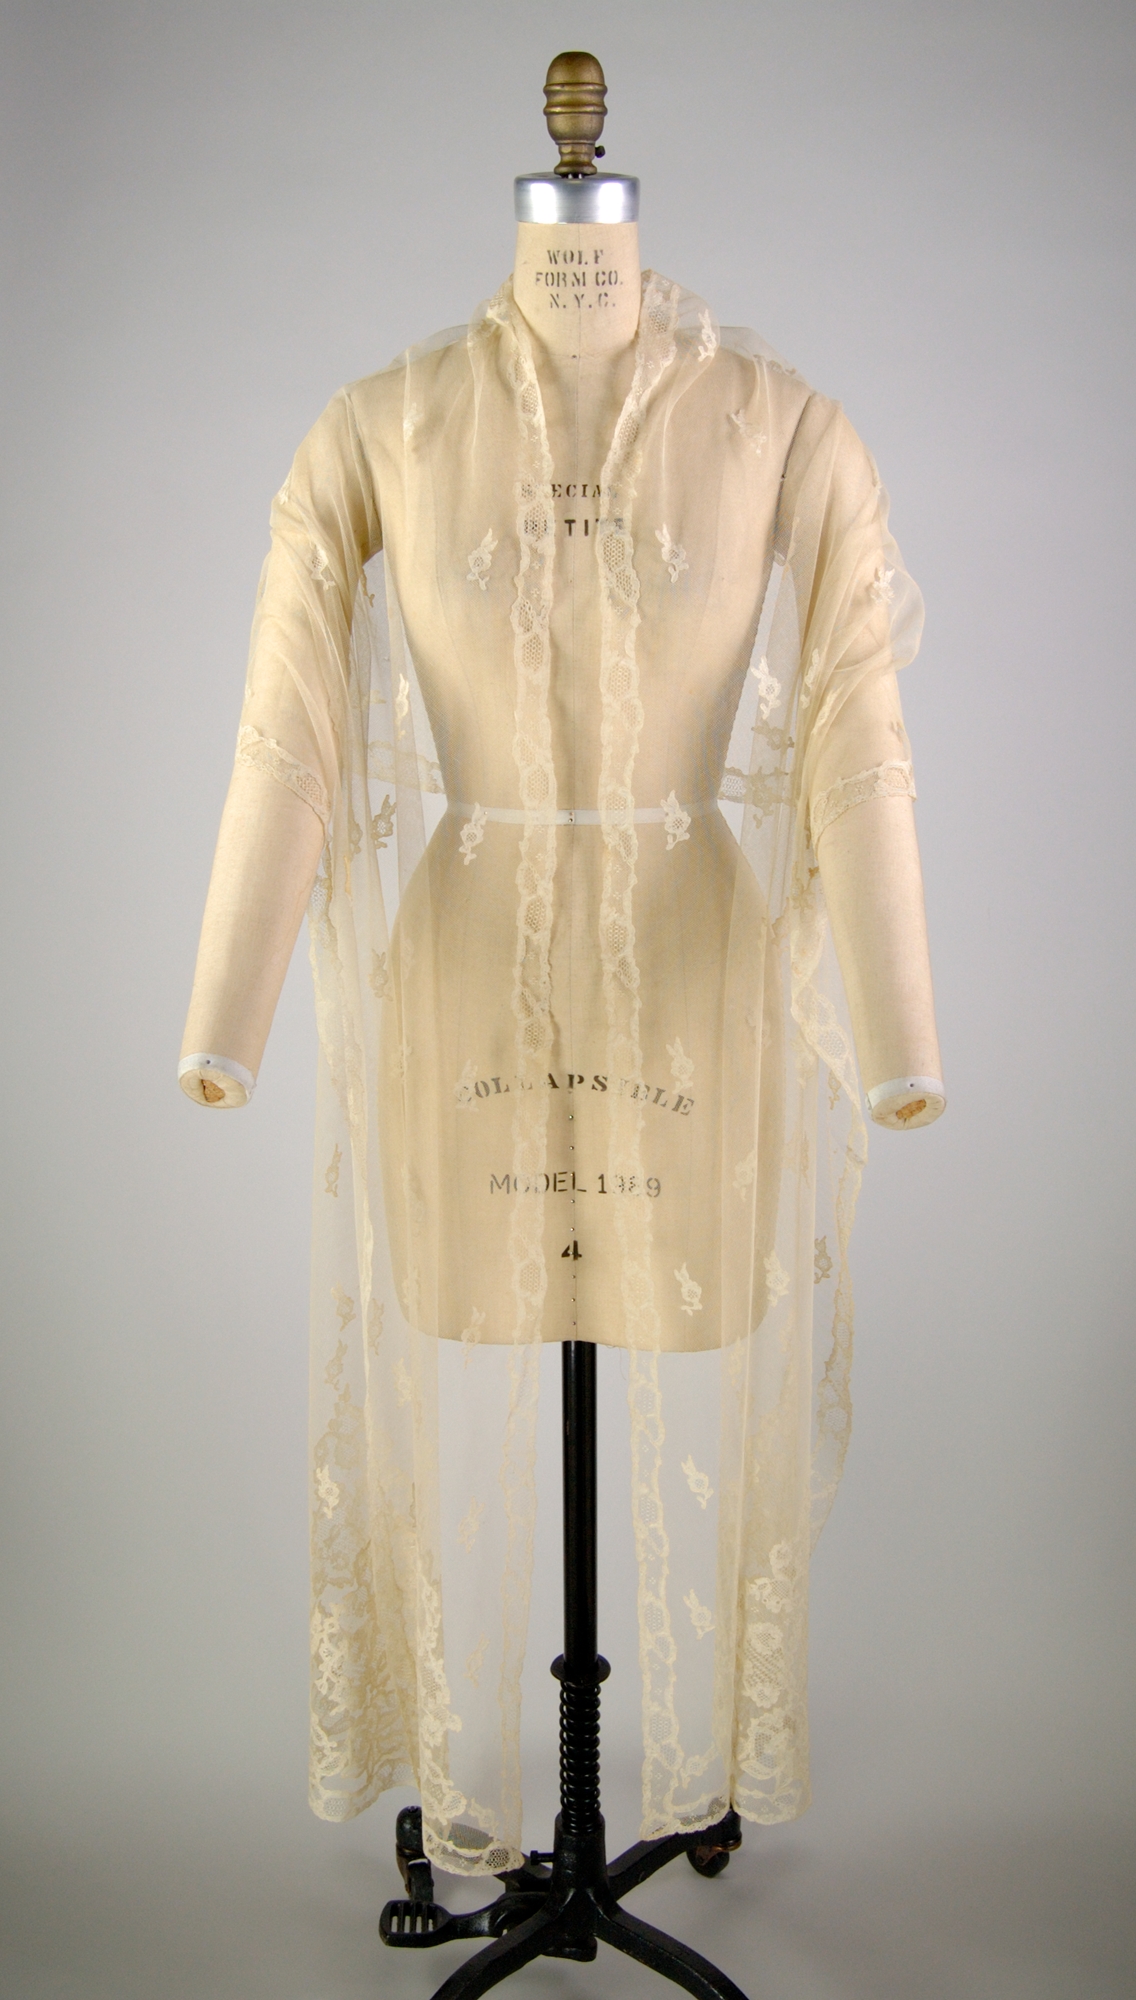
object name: stole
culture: british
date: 1834-1866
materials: cotton, silk